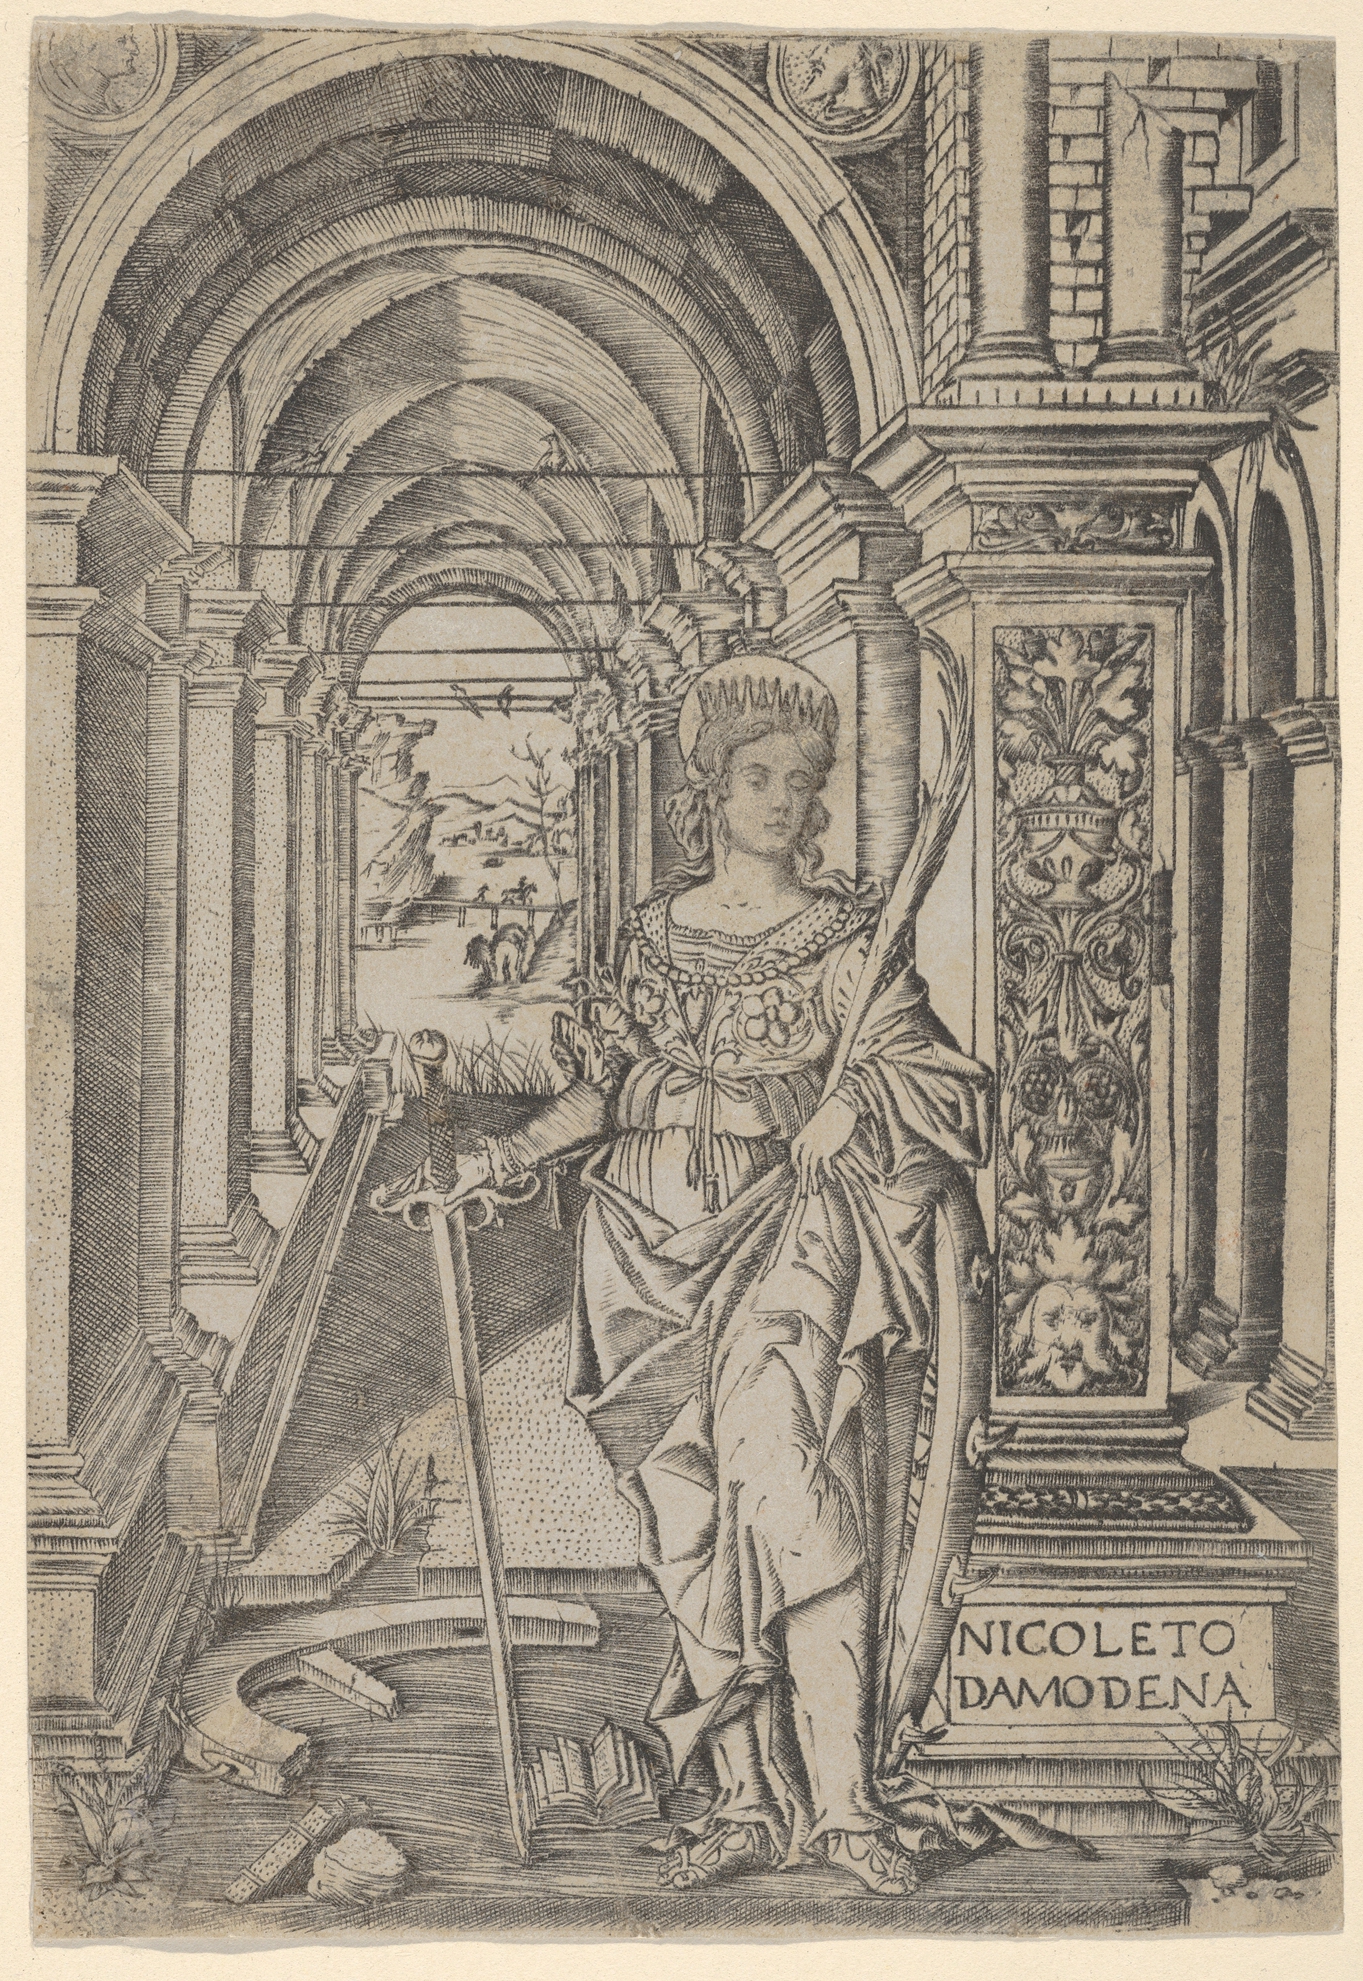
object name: print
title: Saint Catherine, sword in her right hand, palm in her left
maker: nicoletto da modena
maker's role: artist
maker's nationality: italian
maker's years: 1500-1520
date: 1500-1510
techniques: engraving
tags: swords,saint catherine